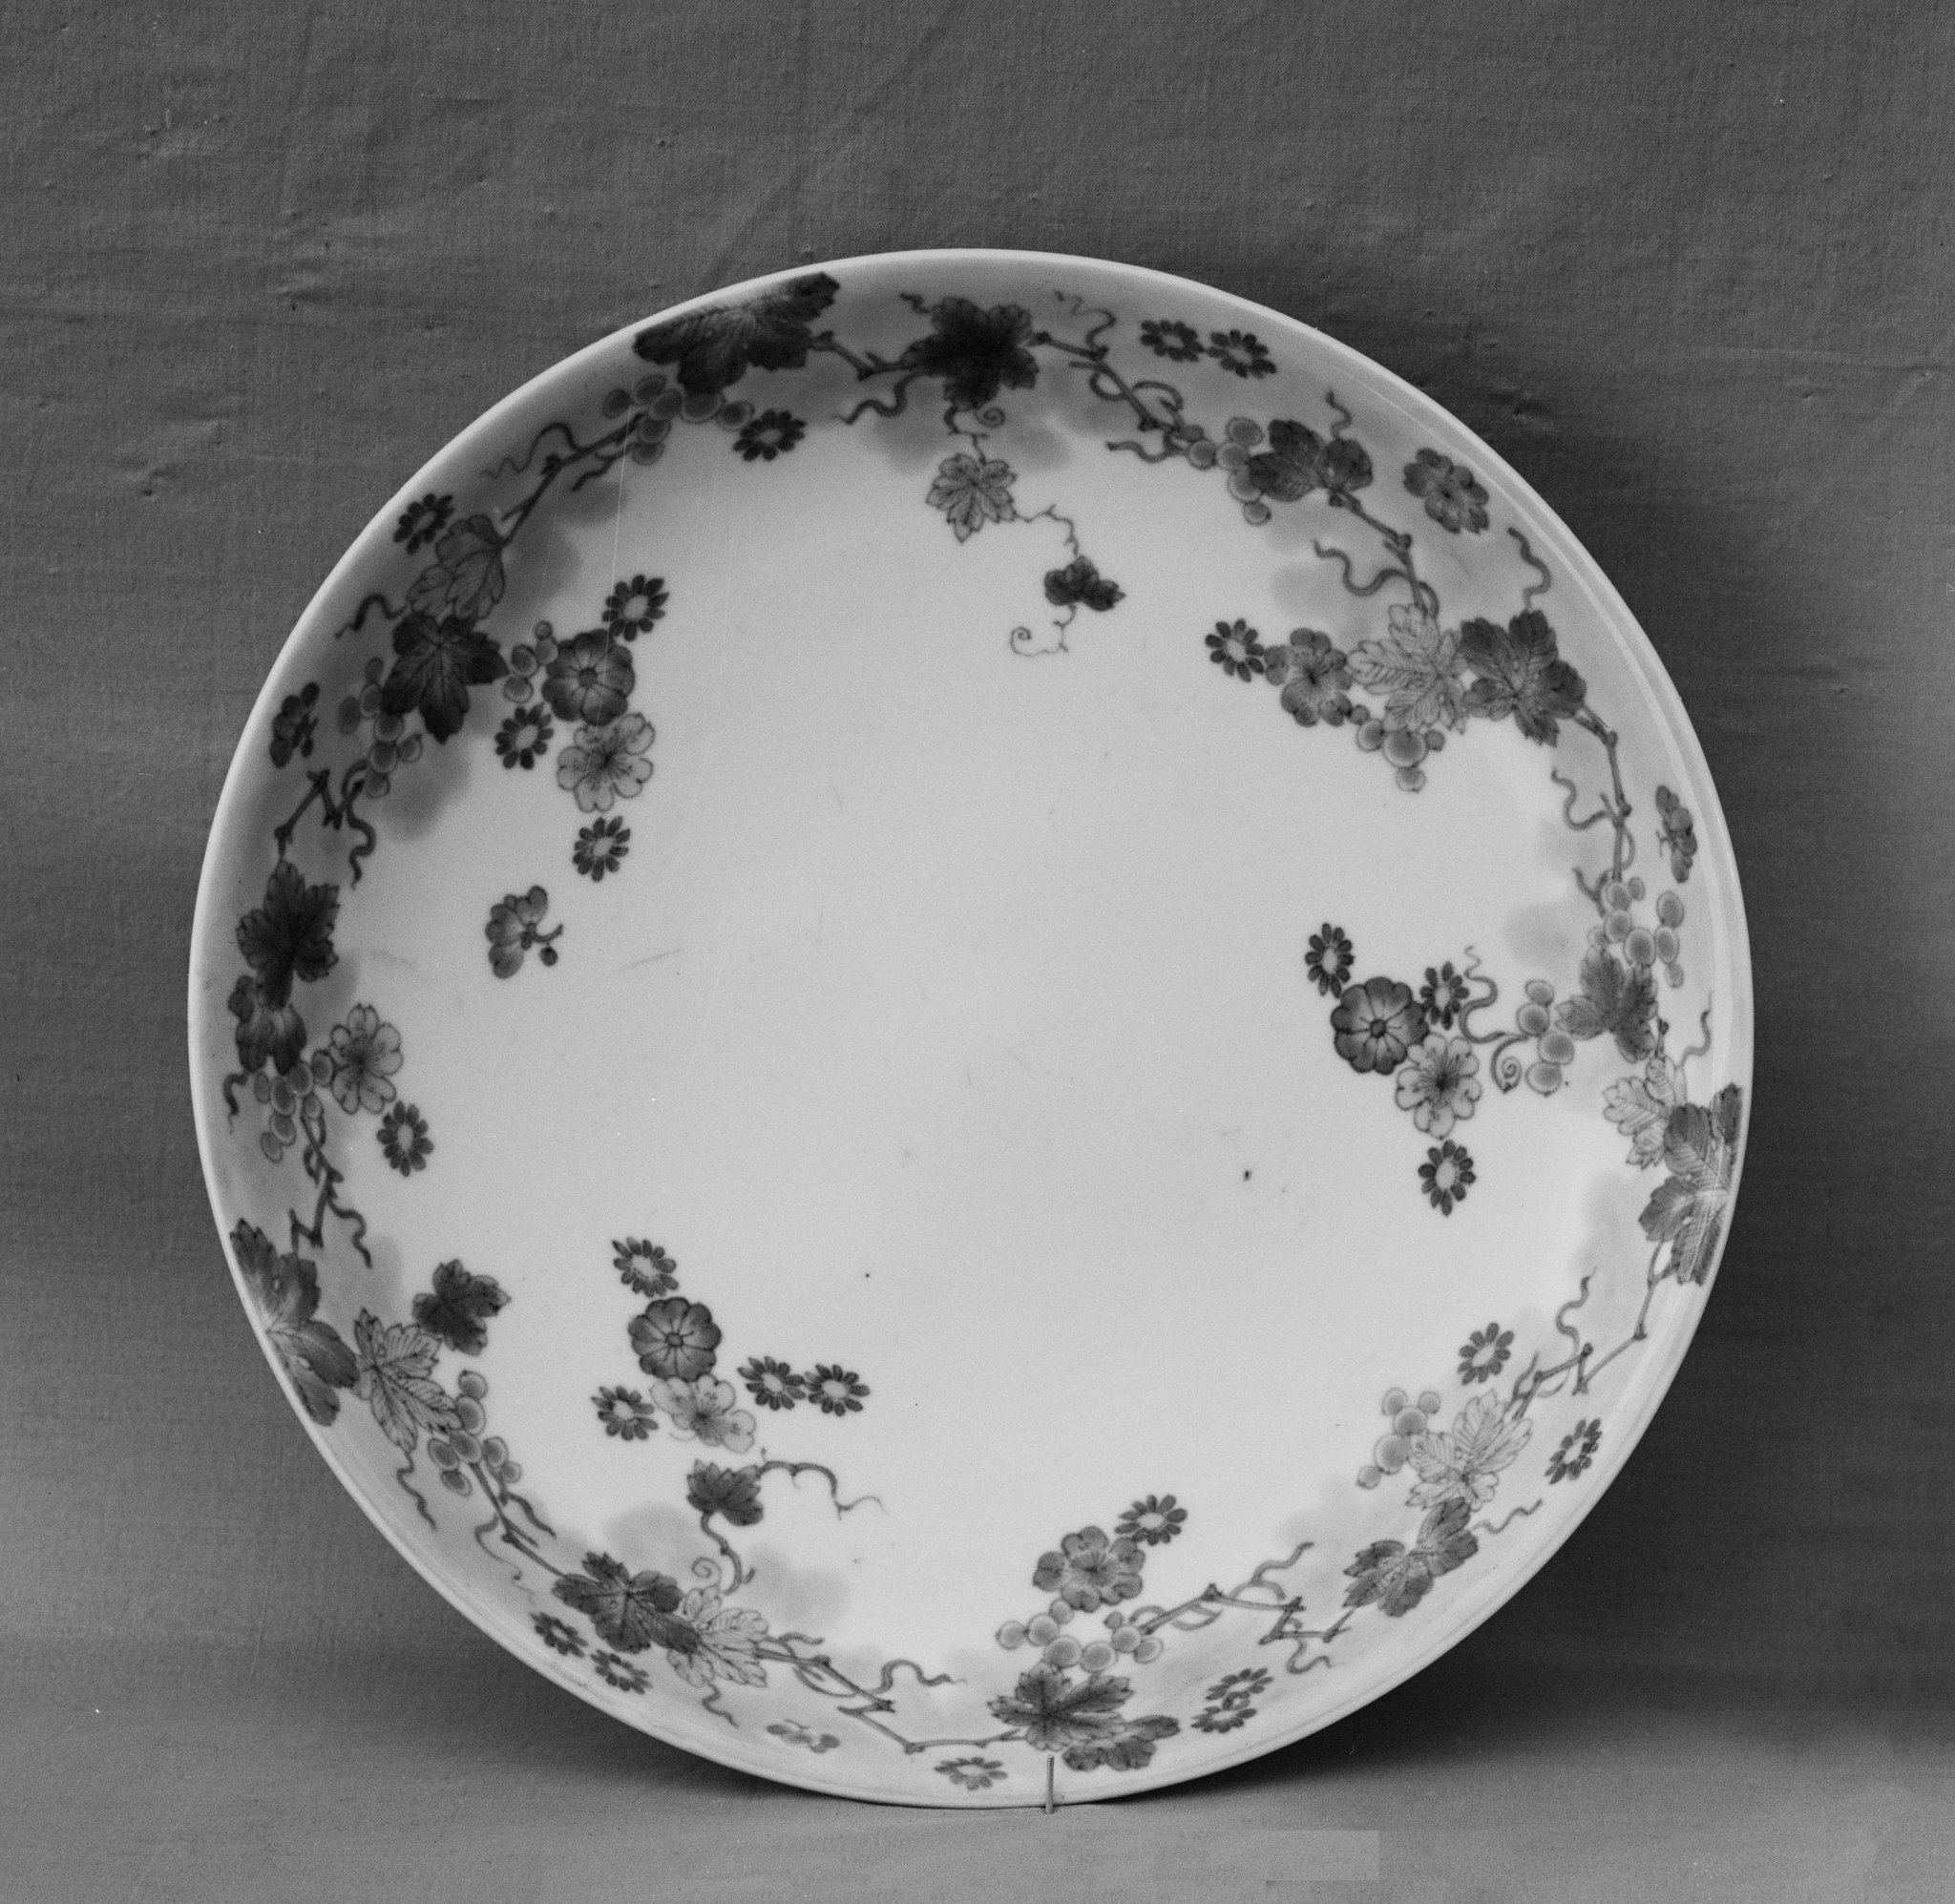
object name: dish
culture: japanese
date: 1701-1800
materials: glaze, porcelain